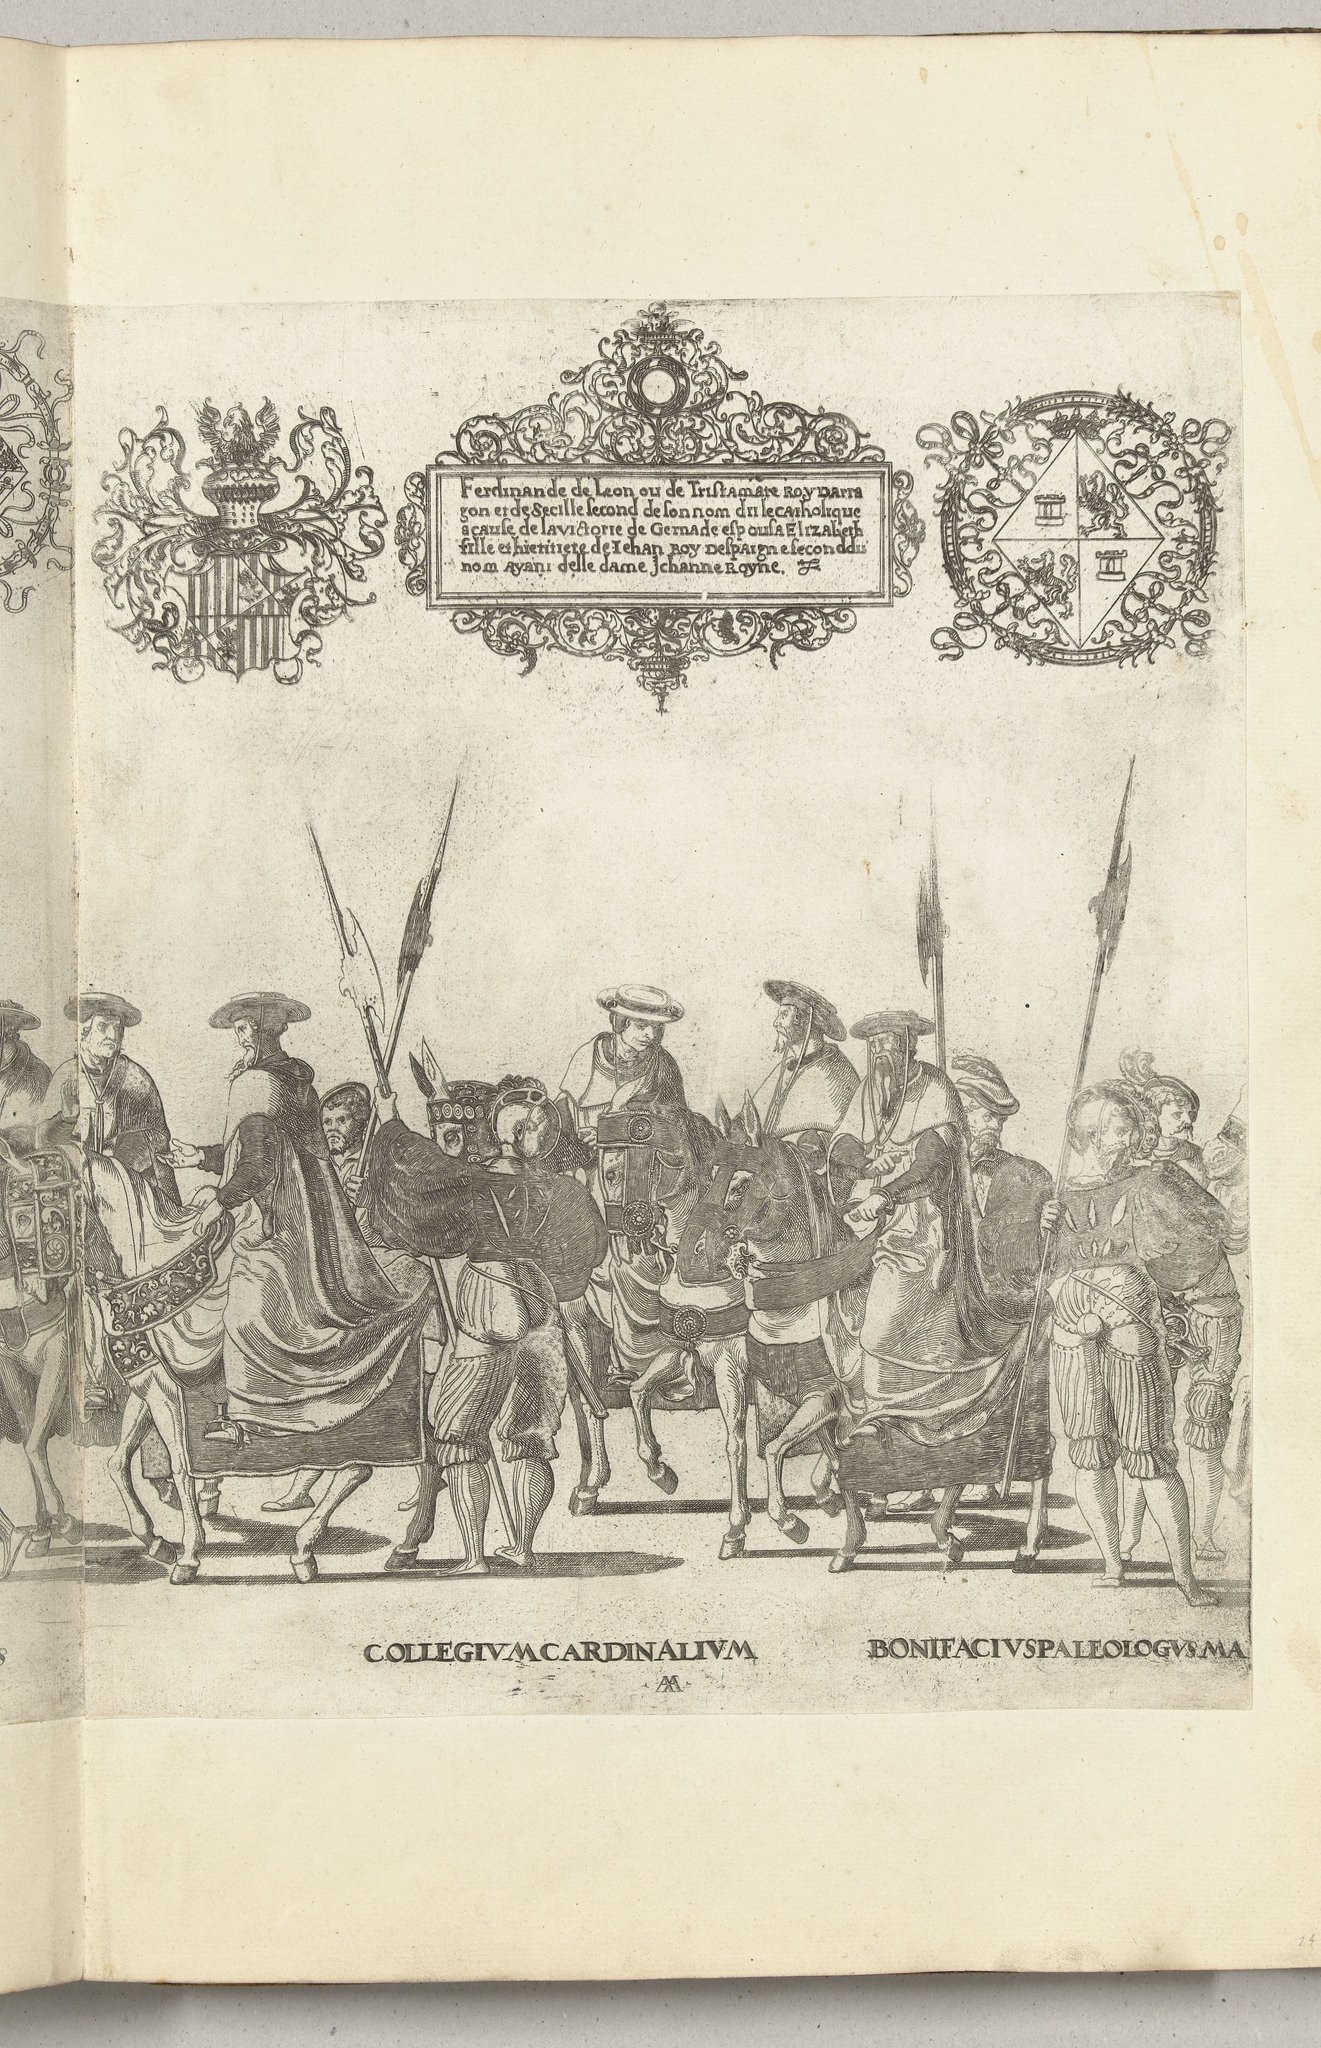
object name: print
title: Optocht van Karel V met de paus te Bologna na zijn kroning to keizer, 1530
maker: nicolaas hogenberg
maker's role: draughtsman, painter, print maker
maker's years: 1500-1539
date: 1530-1536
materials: paper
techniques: etching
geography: mechelen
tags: ghent, charles v (holy roman emperor and king of spain), festivities (+ parade, pageant, cavalcade ~ festive activities)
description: Prent in het album waarin zijn ingeplakt de 40 platen die achterelkaar samen het fries vormen van de optocht van Karel V met de paus Clemens VII te Bologna na zijn kroning tot keizer, 24 februari 1530.